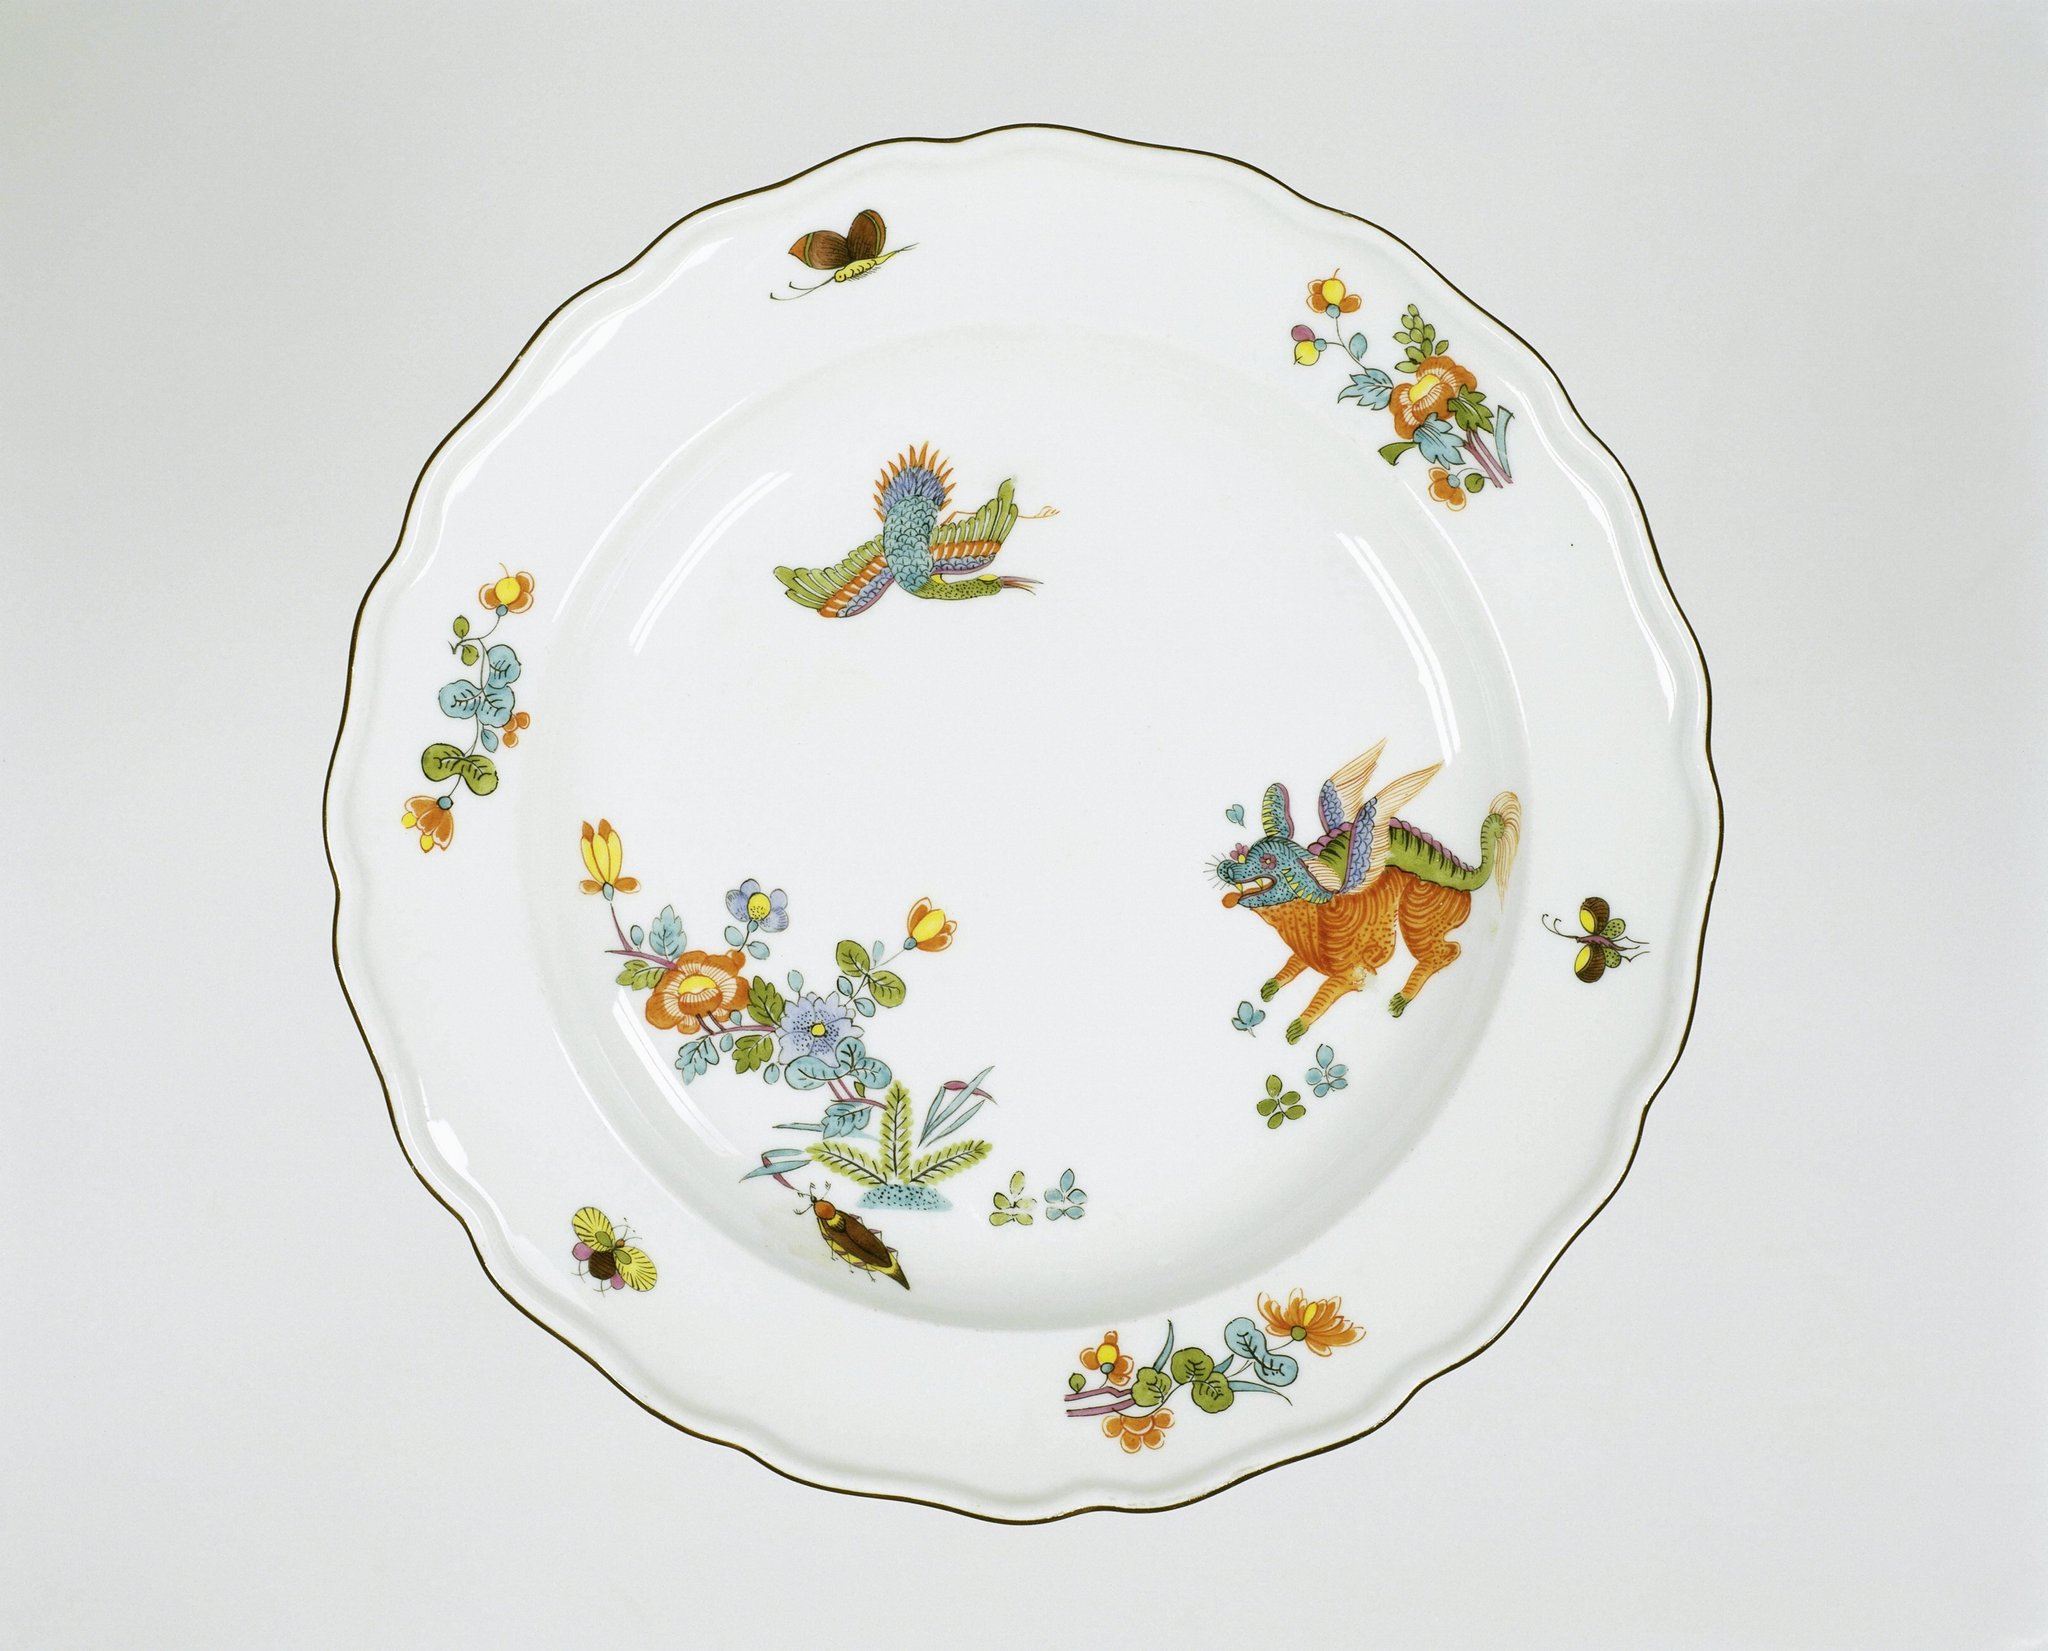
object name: eating drinking utensil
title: Bord, veelkleurig beschilderd met een Kakiemon-decor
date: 1800-1900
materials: porcelain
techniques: painted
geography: meissen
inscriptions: model number: ‘M 12’, factory mark, mold mark: ‘10’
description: Rond bord van beschilderd porselein, vervaardigd naar een model van omstreeks 1735. Het bord heeft een geschulpte rand en is beschilderd met een draak, een vliegende vogel en bloemtakken. Het bord is gemerkt.